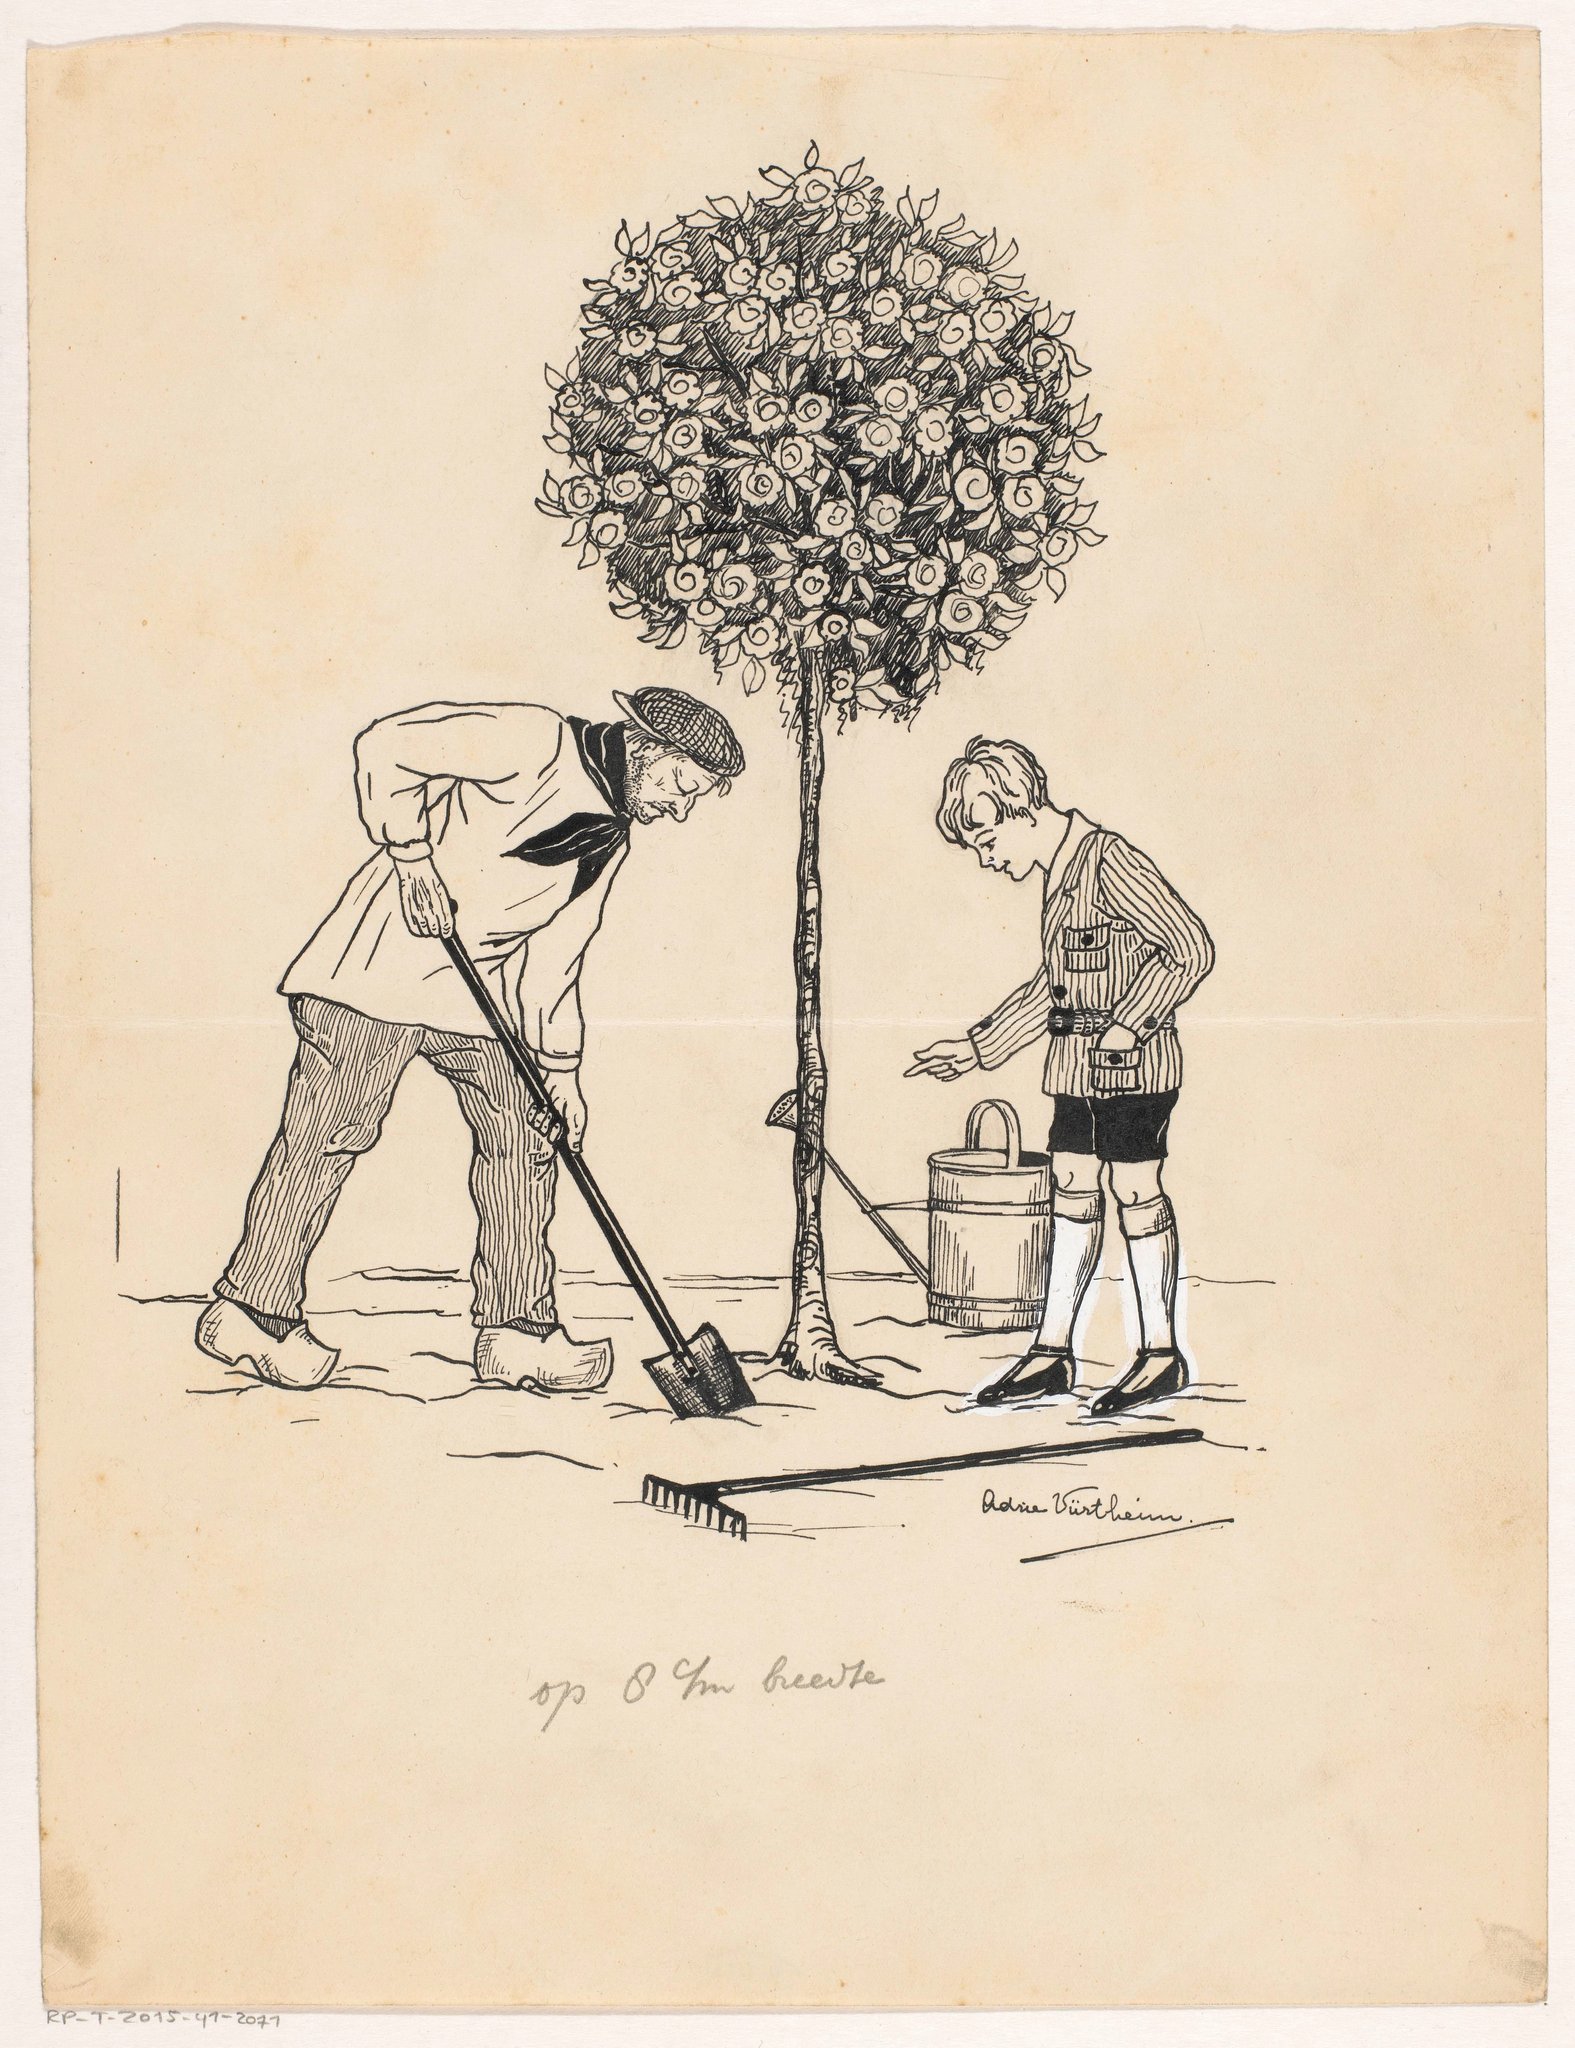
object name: drawing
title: Tuinierende jongen en man bij een rozenboom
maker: adrie vürtheim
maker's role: draughtsman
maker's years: 1907-1995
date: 1917-1970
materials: paint, ink, paper, pencil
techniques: brush, pen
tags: shrubs: rose-bush, spading ~ soil cultivation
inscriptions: signature: ‘Adrie Vürtheim.’, collector's mark: Lugt 2228a, :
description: Een man steekt een schep in de aarde naast een rozenboom. Hij draagt een pet en klompen en heeft een sjaal om de nek geknoopt. Een jongen kijkt toe en wijst naar de aarde. Achter hem staat een gieter.